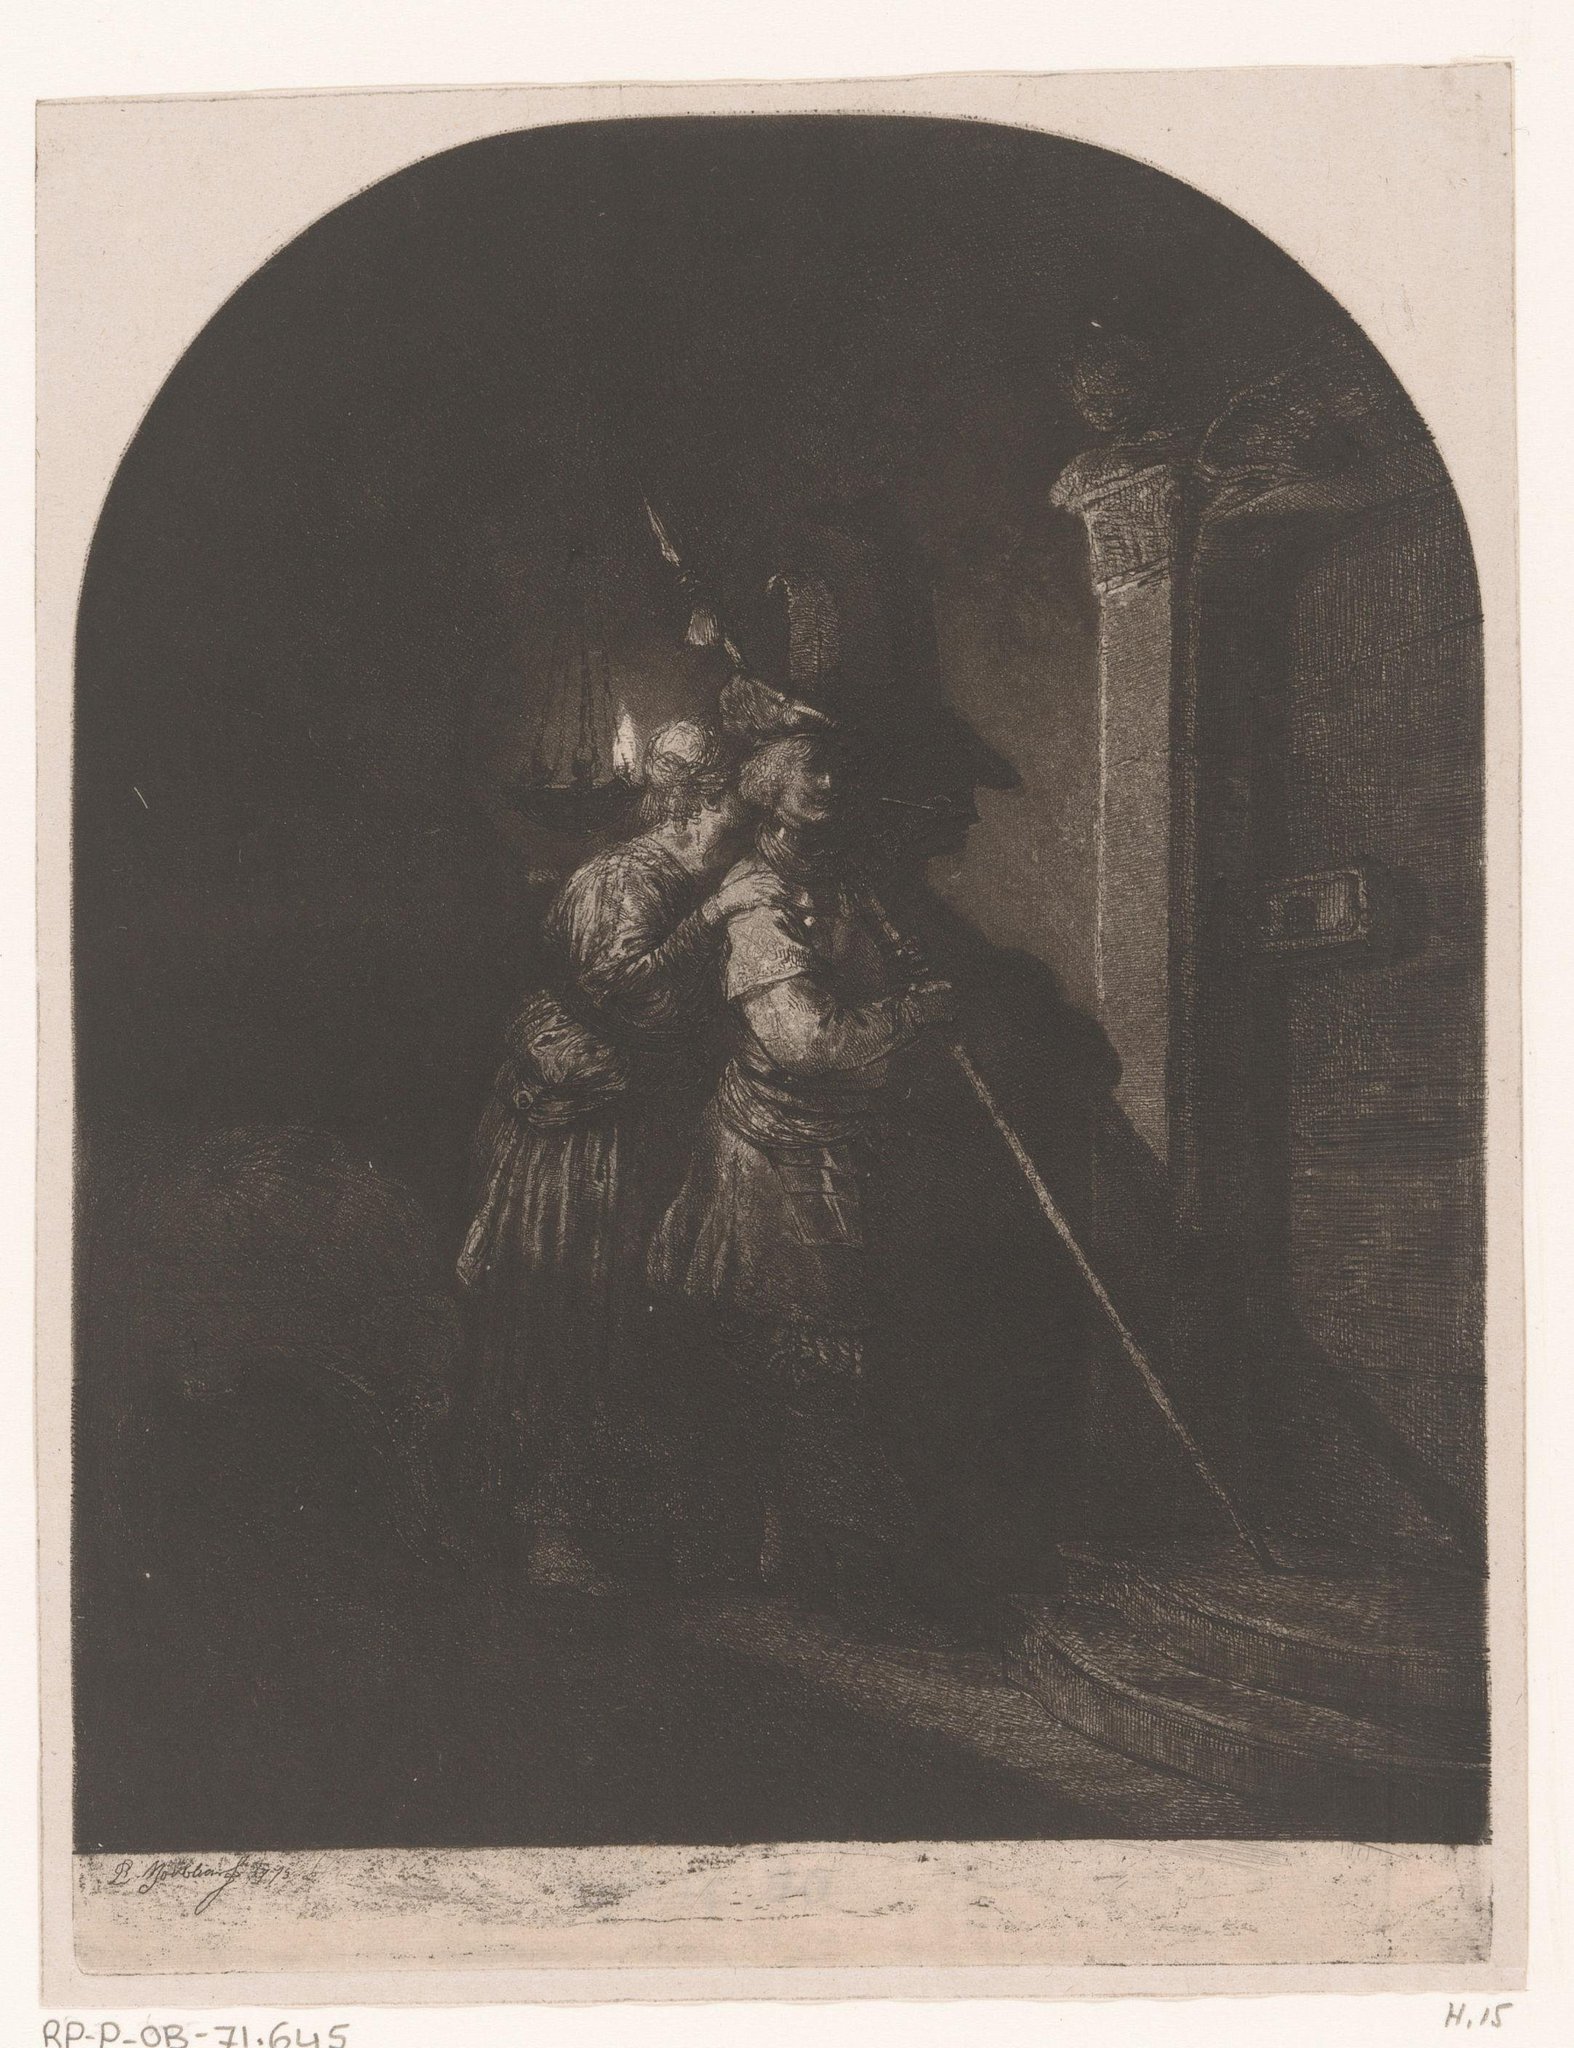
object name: print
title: Uitvinding van de tekenkunst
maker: jean pierre norblin de la gourdaine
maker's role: print maker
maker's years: 1745-1830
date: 1775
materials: paper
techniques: drypoint, etching, intaglio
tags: man and his shadow, drawing, the origin of painting and drawing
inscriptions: collector's mark: Lugt 2228